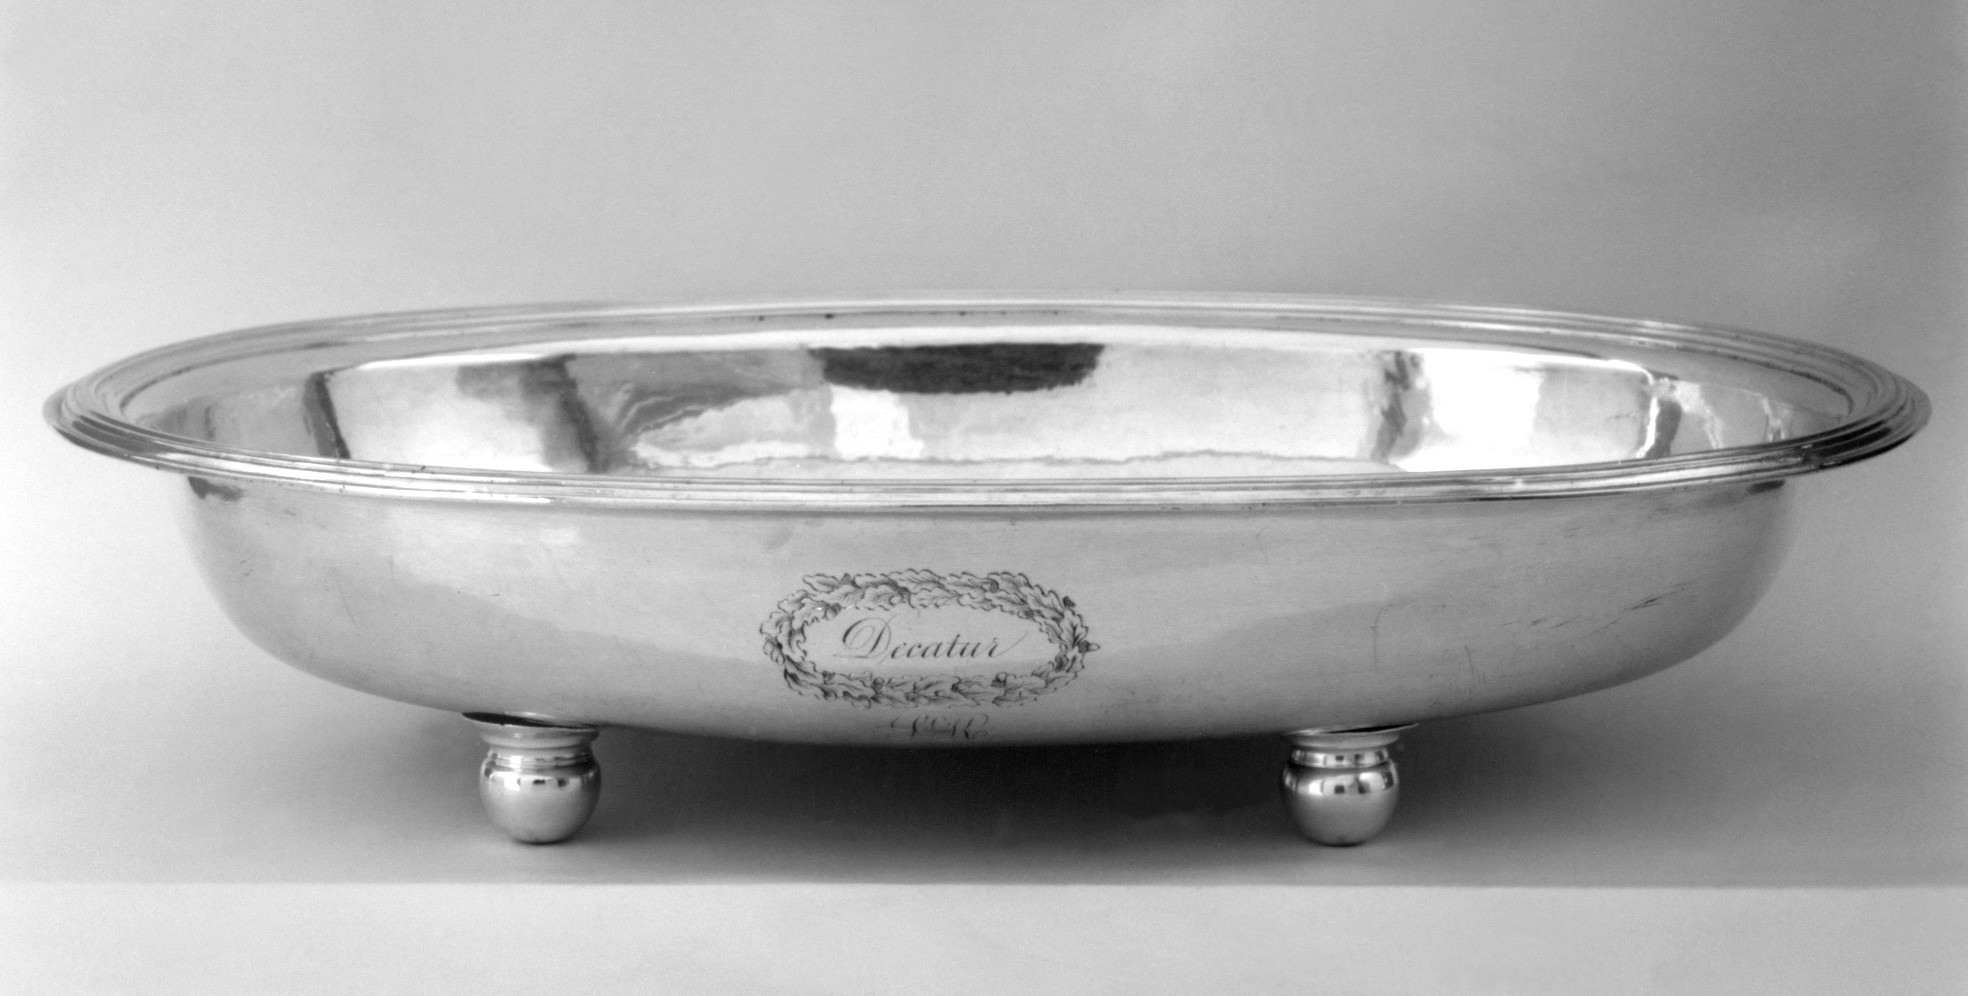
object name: dish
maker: pierre-joseph dehanne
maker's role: maker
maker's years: 1751-1851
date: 1787-1788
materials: silver